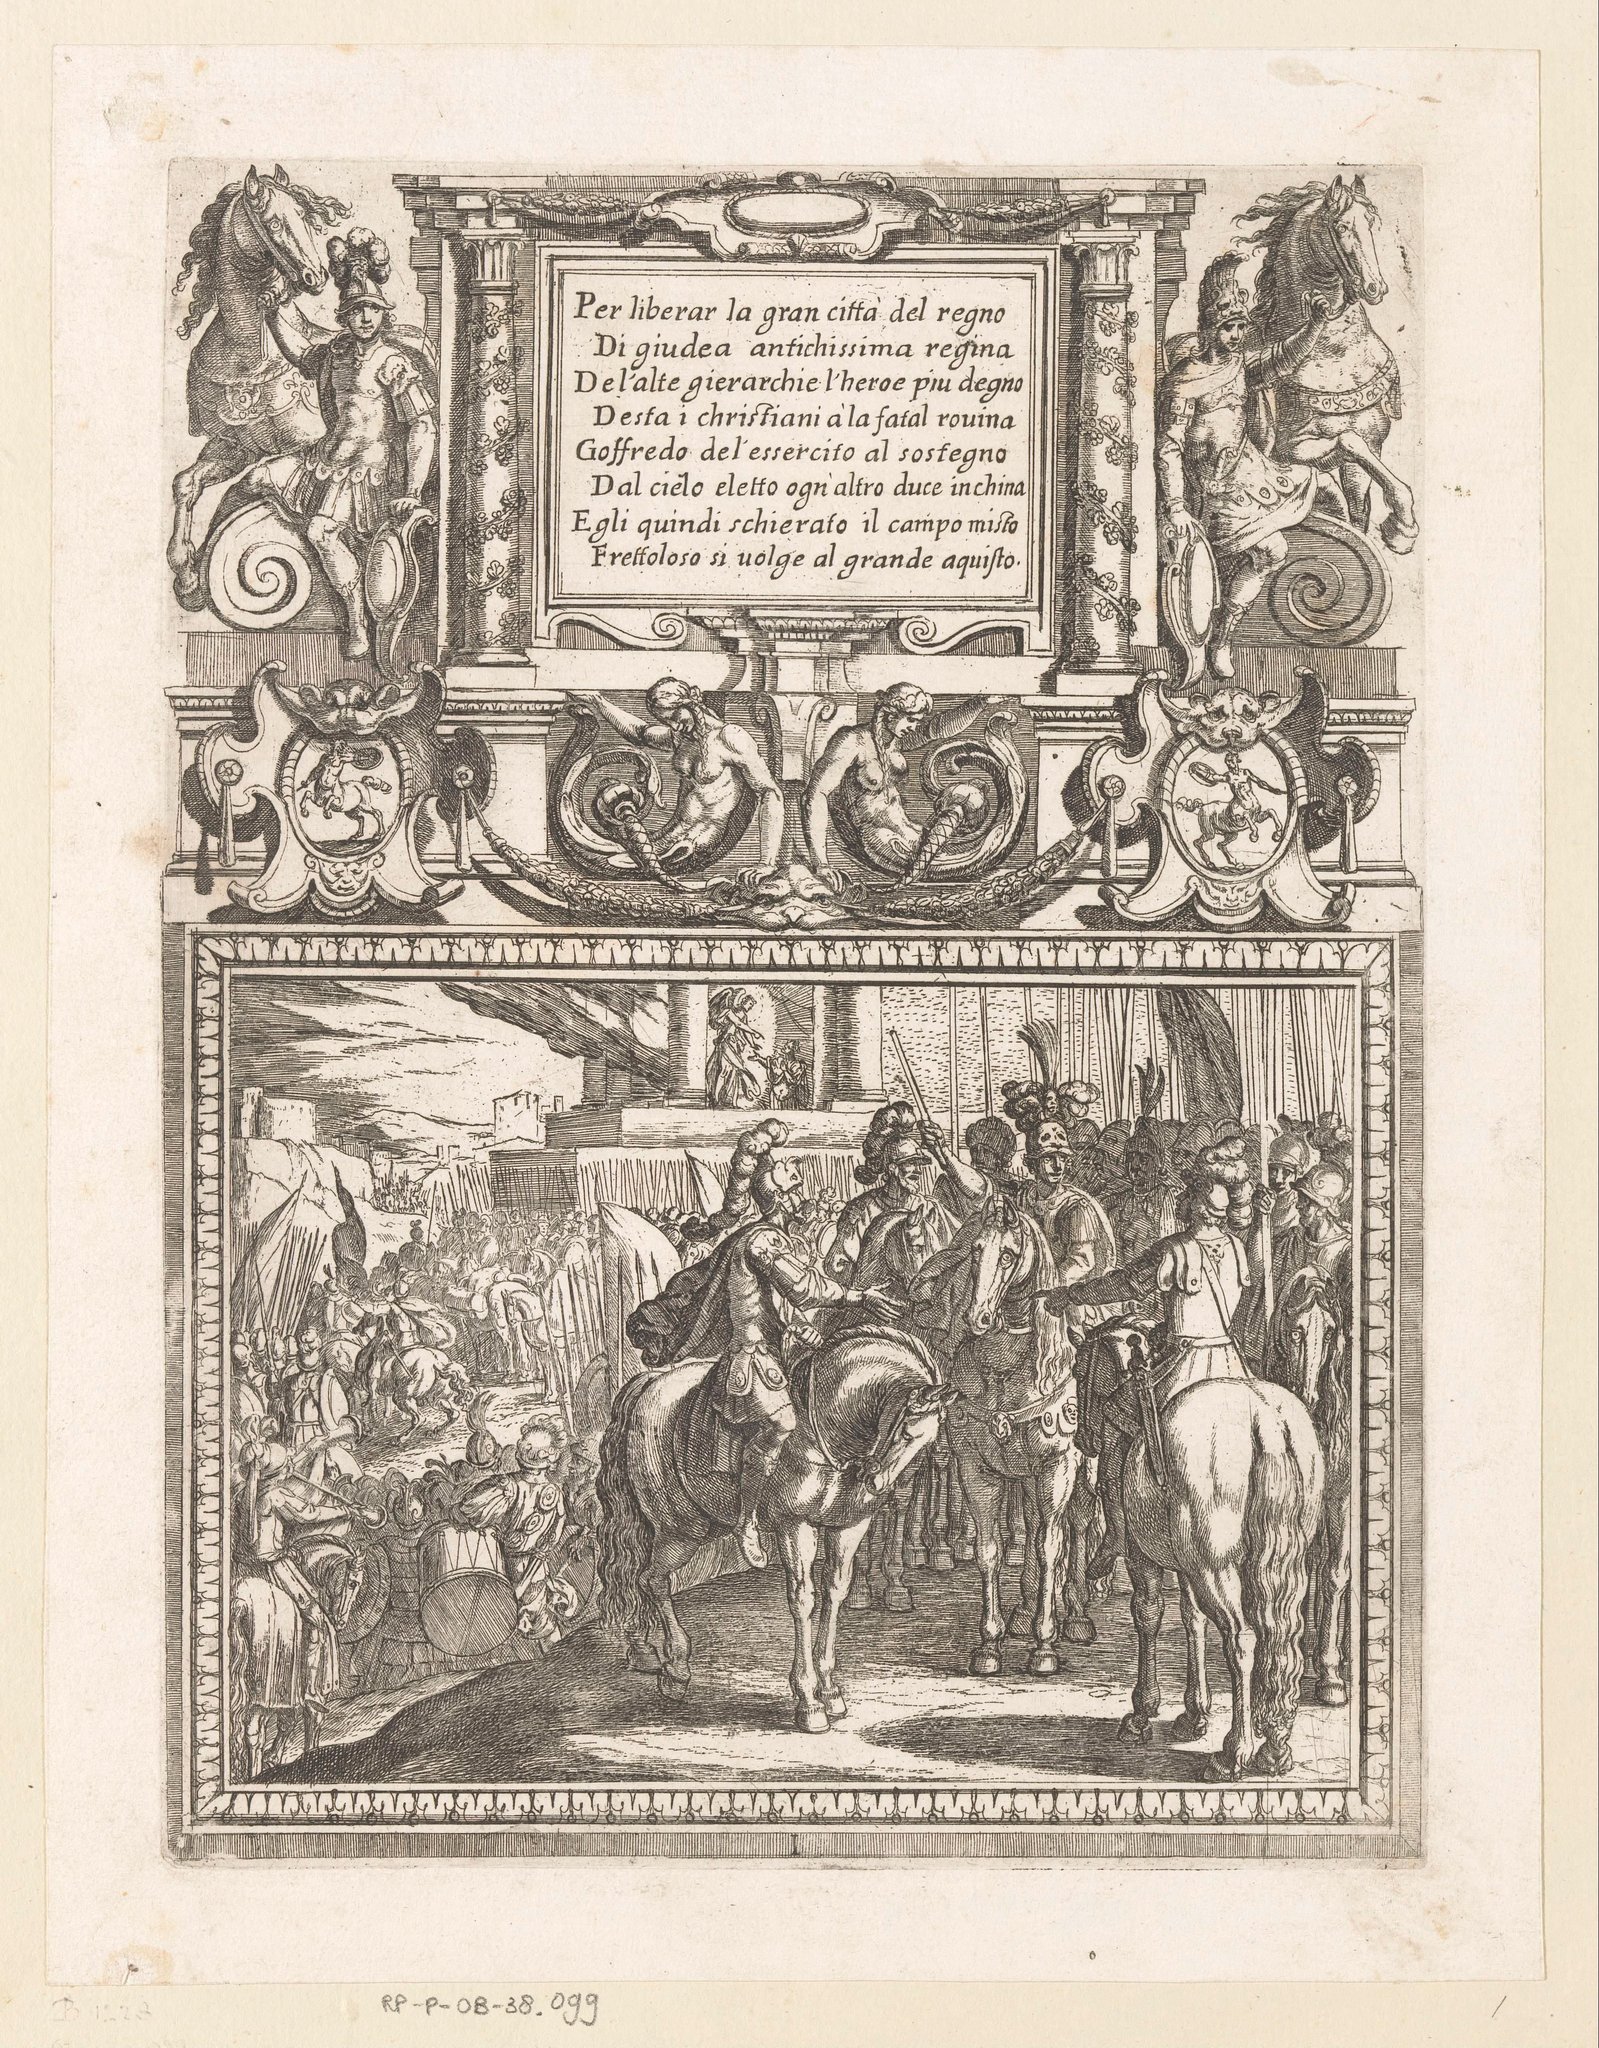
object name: print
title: Gerusalemme Liberata (deel 3)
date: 1565-1630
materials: paper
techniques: etching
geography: italy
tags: godfrey of bouillon, ornaments ~ art, militant proselytizing: religious war, crusade, etc., ornament ~ cartouche, (scenes from) specific works of literature: tasso, gerusalemme liberata, knight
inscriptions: collector's mark: Lugt 240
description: Deze prent maakt deel uit van een reeks van twintig prenten met ornamentele sierlijsten met daarin voorstellingen van scènes uit Tasso's 'Jeruzalem verlost', een episch gedicht geschreven door de Italiaanse dichter Torquato Tasso en voor het eerst gepubliceerd in 1581. Het verhaal vertelt grotendeels in fictie over de Eerste Kruistocht waarin de christenen, geleid door Godfried van Bouillon, de strijd aangaan met de moslims om het Beleg van Jeruzalem.